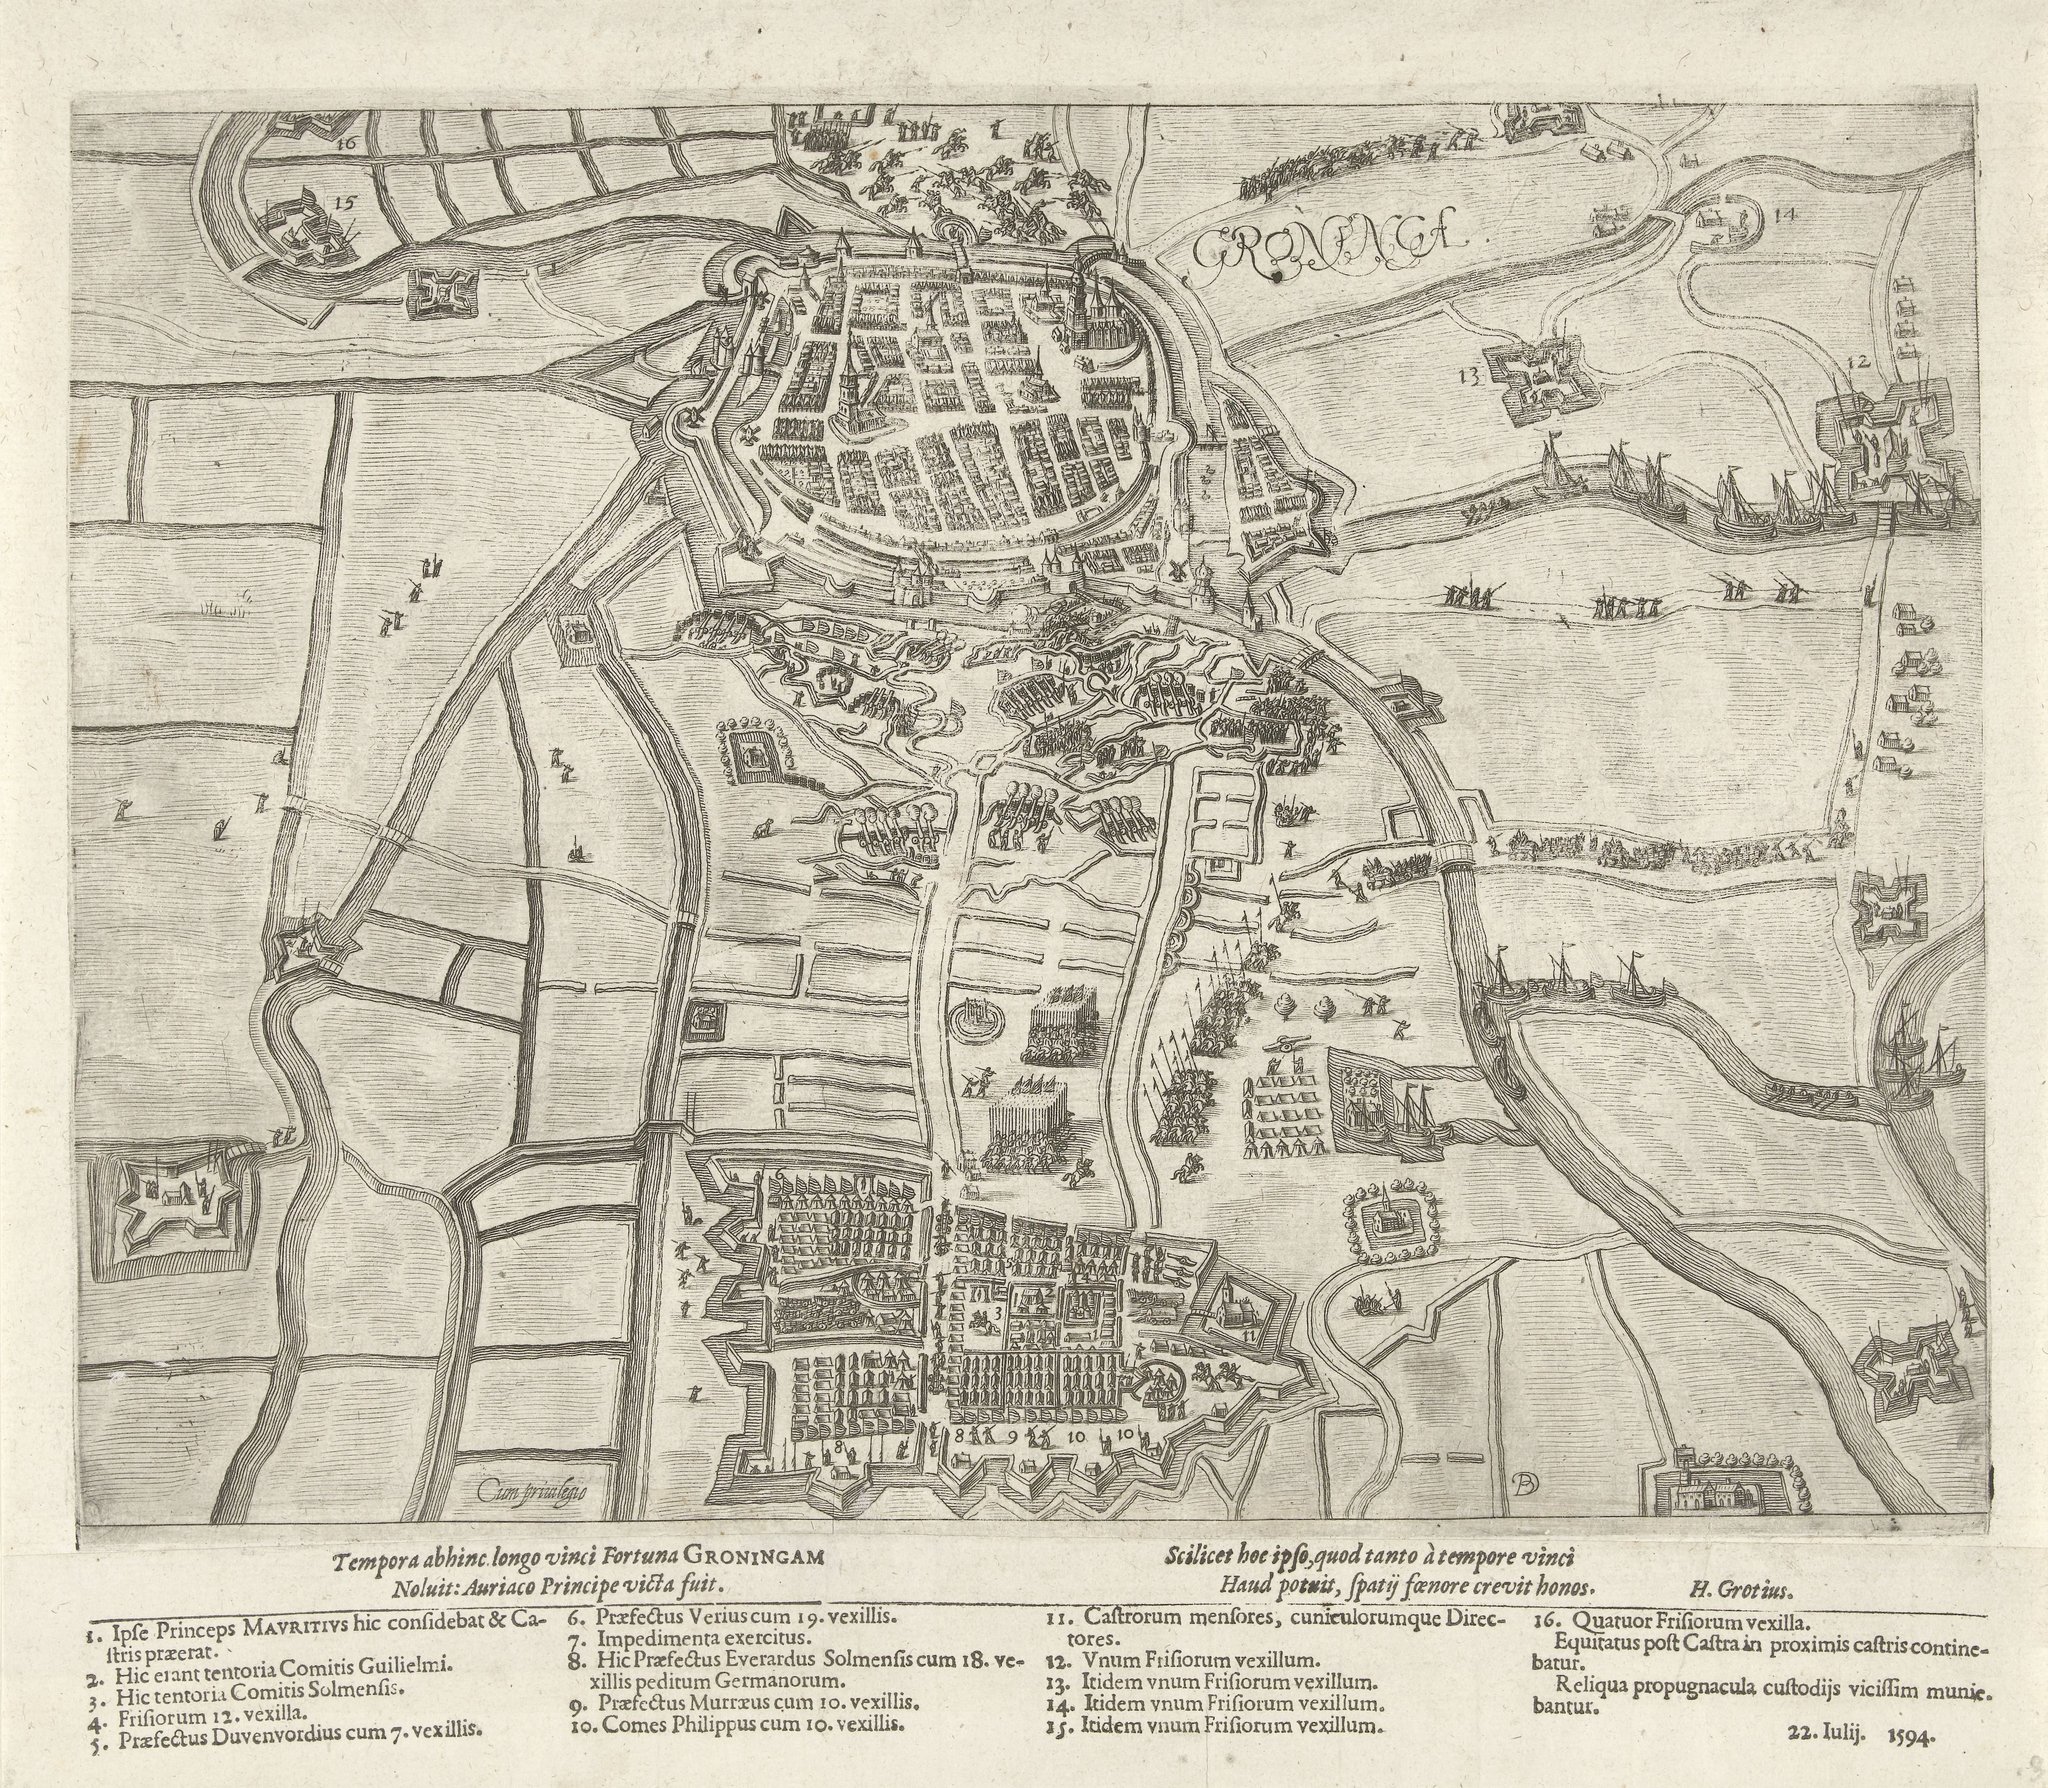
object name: history print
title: Beleg van Groningen, 1594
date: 1600-1601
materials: paper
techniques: engraving, letterpress printing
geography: northern netherlands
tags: maurice (prince of orange), siege, position war, trenches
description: De plaat is later gebruikt als illustratie in: J.J. Orlers, Den Nassauschen Lauren-Crans: Beschrijvinghe ende af-beeldinge van alle de victorien ... die Godt Almachtich de ... Staten der Vereenichde Nederlanden verleent heeft, deur het wijs ende clouck beleyt des Hooch-ghebooren Fursts Maurits van Nassau, J.J. Orlers en H. van Haestens, Leiden 1610, fol. 98/99.